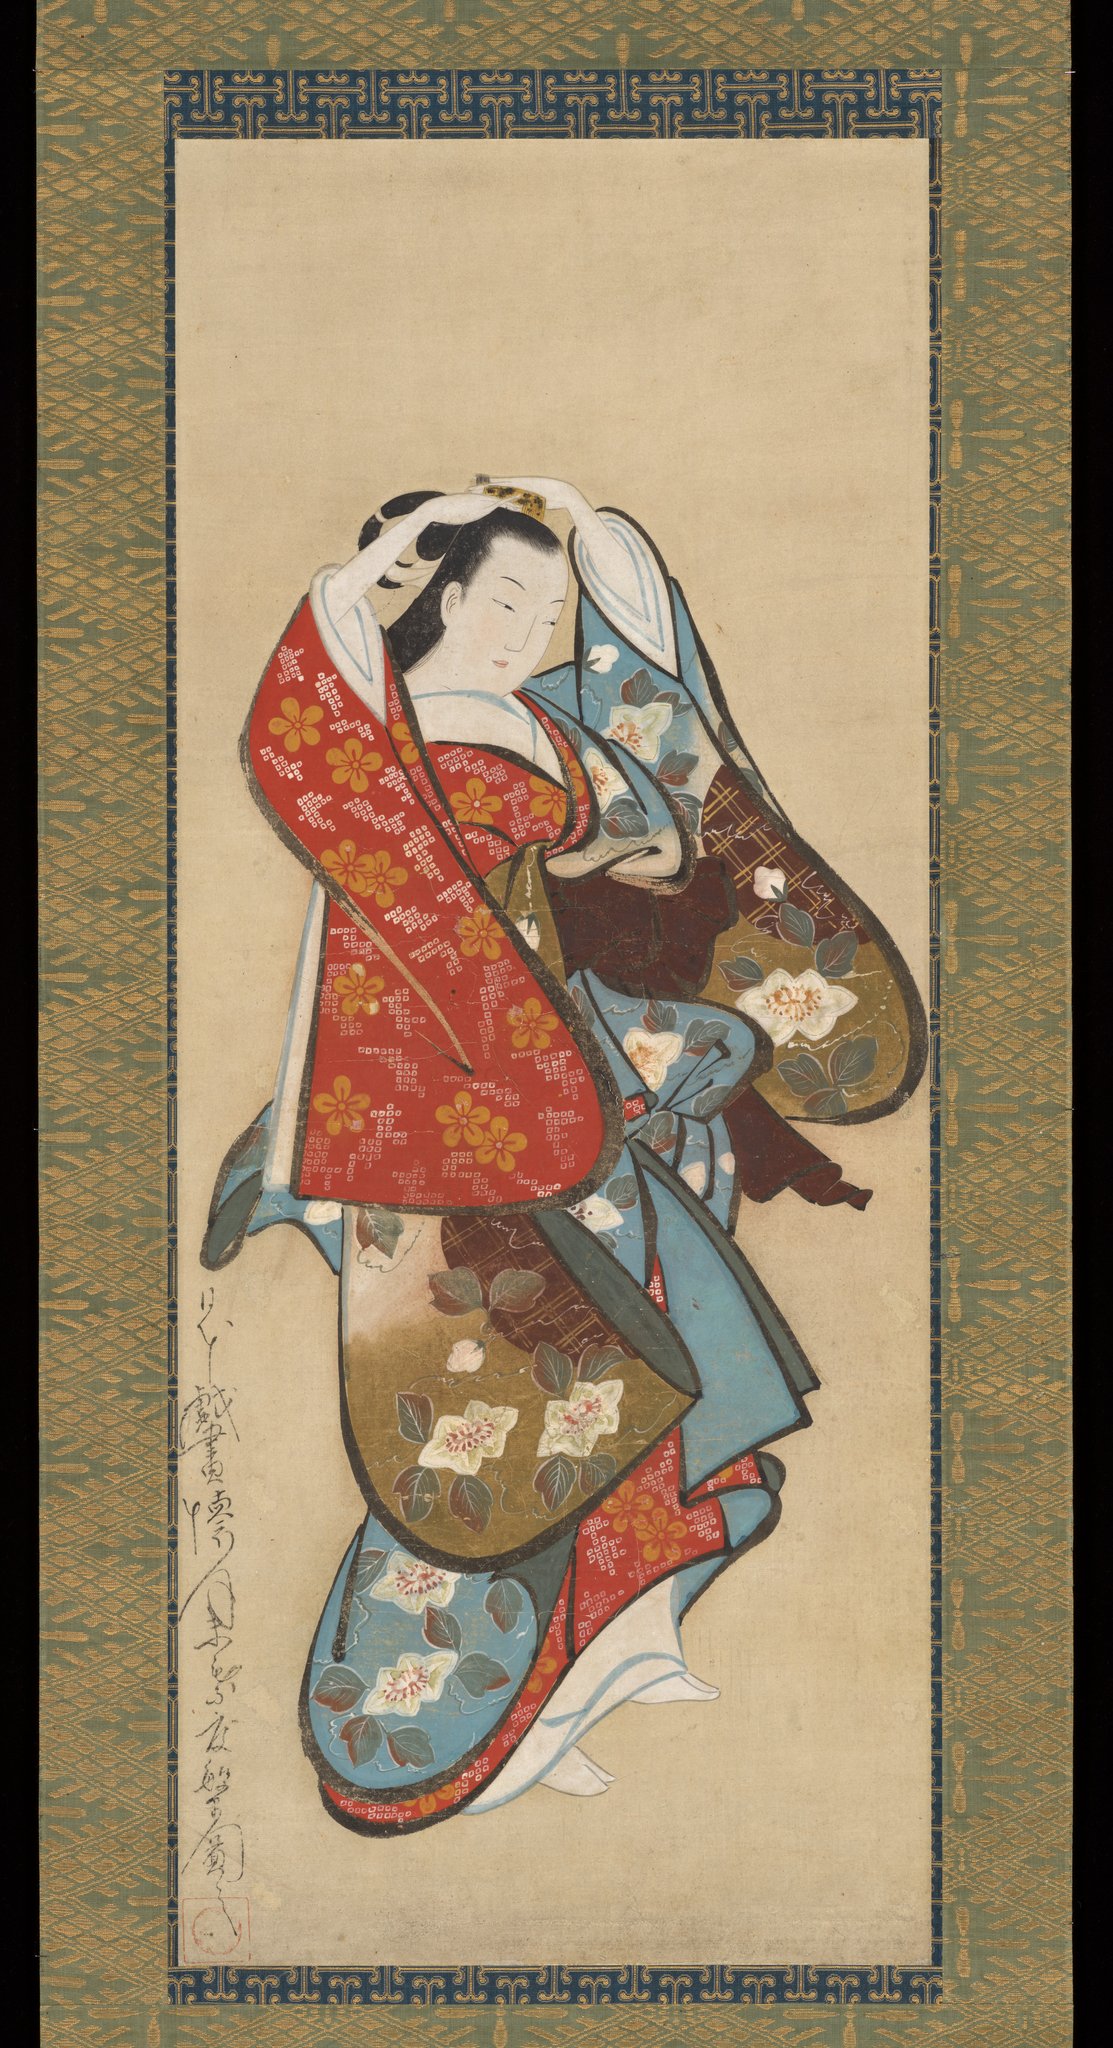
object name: hanging scroll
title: Beautiful Woman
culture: japanese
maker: kaigetsudō dohan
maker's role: artist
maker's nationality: japanese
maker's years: 1710-1716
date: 1701-1733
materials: ink, paper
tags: women